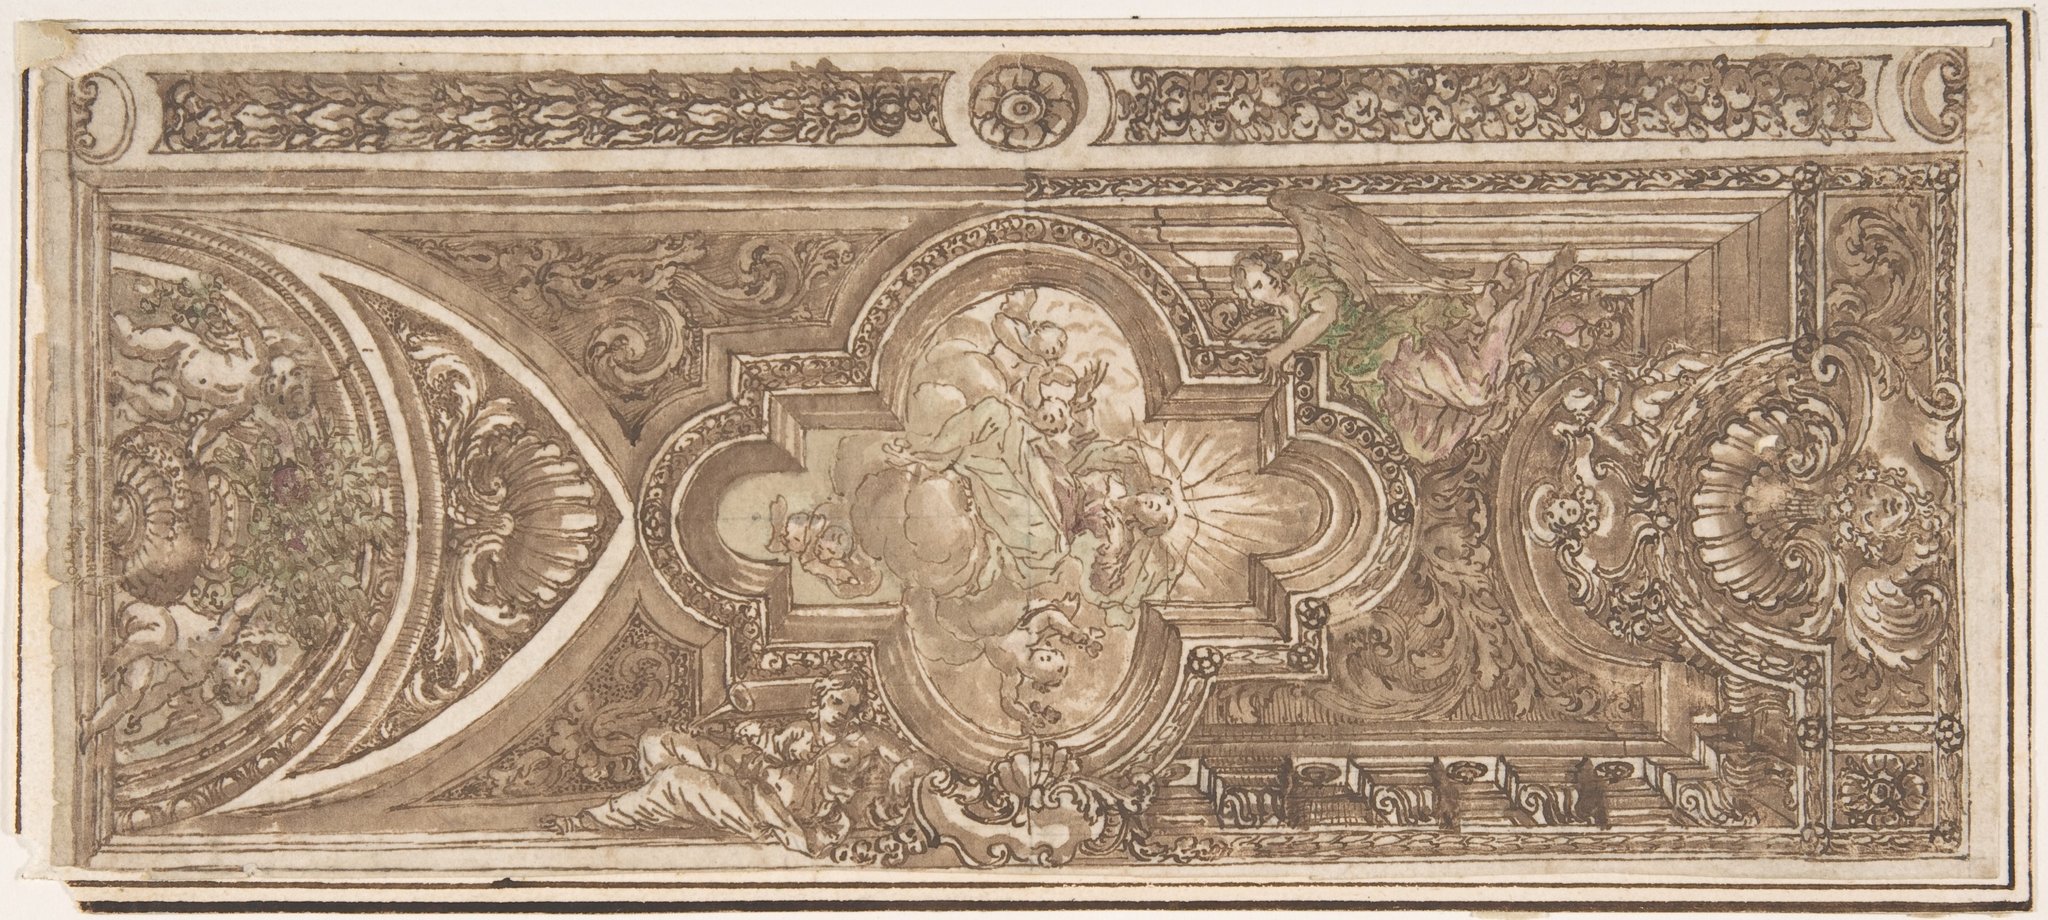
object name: drawing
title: Design for a Ceiling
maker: anonymous, italian, roman-bolognese, 17th century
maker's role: artist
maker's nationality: italian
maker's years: 1600-1700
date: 1601-1700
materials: chalk, ink, paper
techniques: brush, pen, wash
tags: women,putti,angels